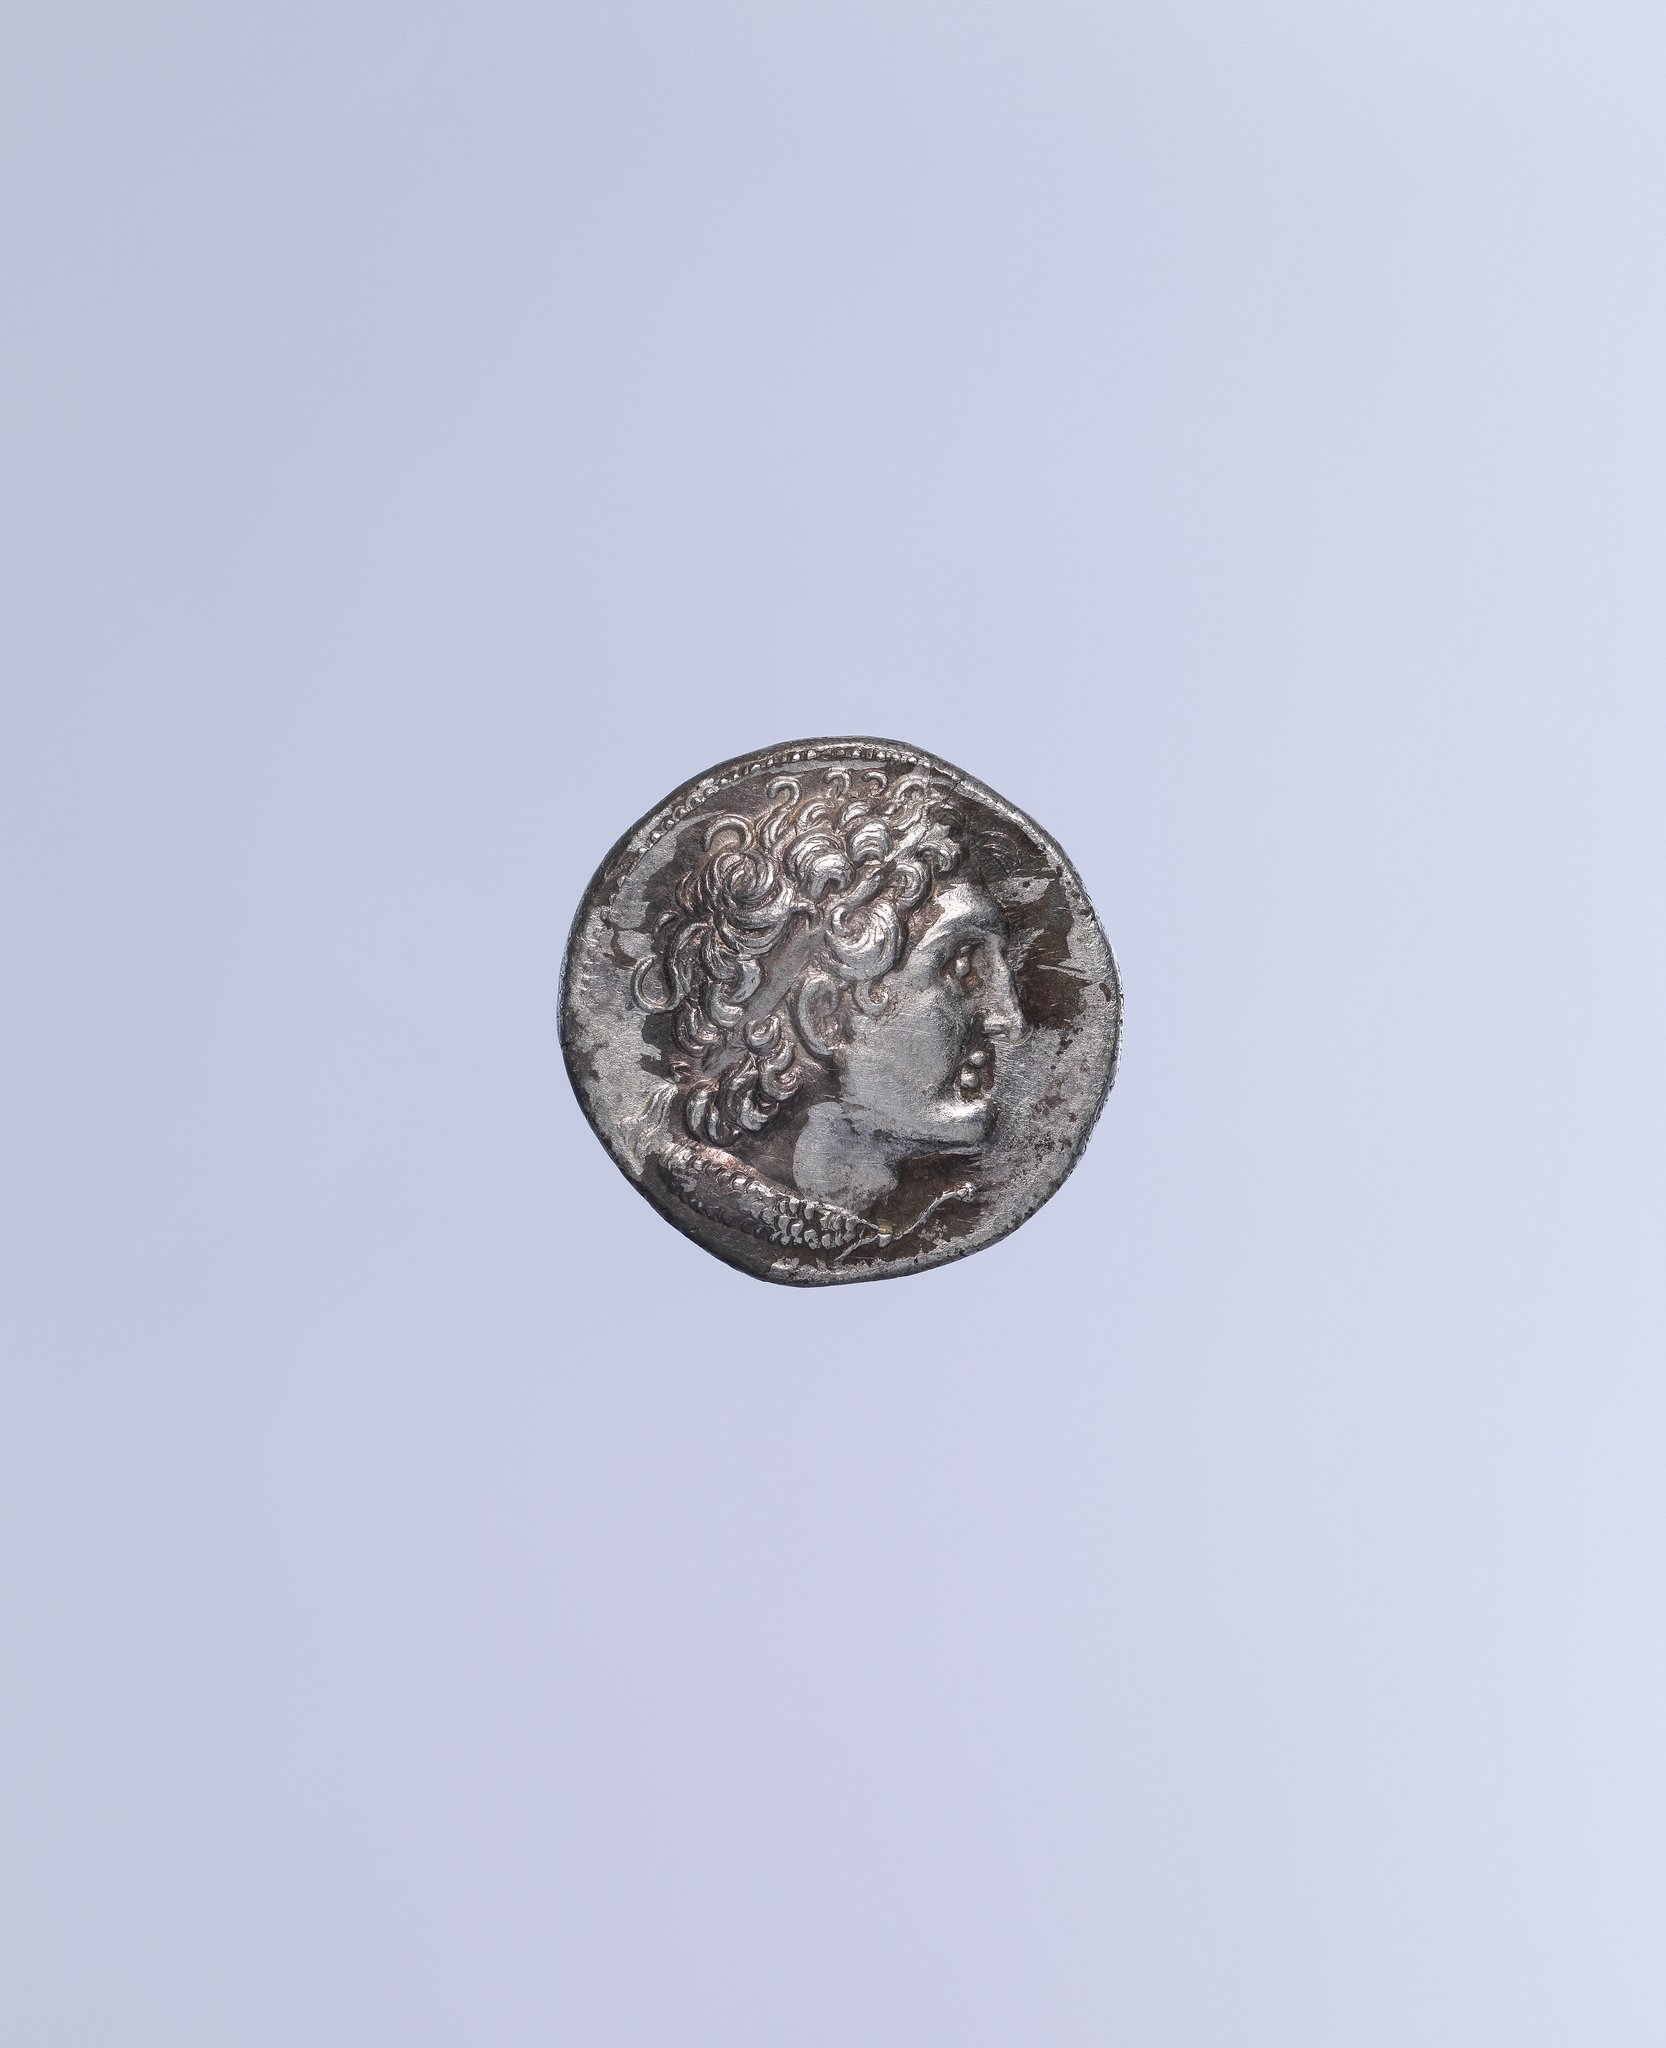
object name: tetradrachm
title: Silver tetradrachm of Ptolemy VIII Euergetes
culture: ptolemaic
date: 164-145 BCE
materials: silver